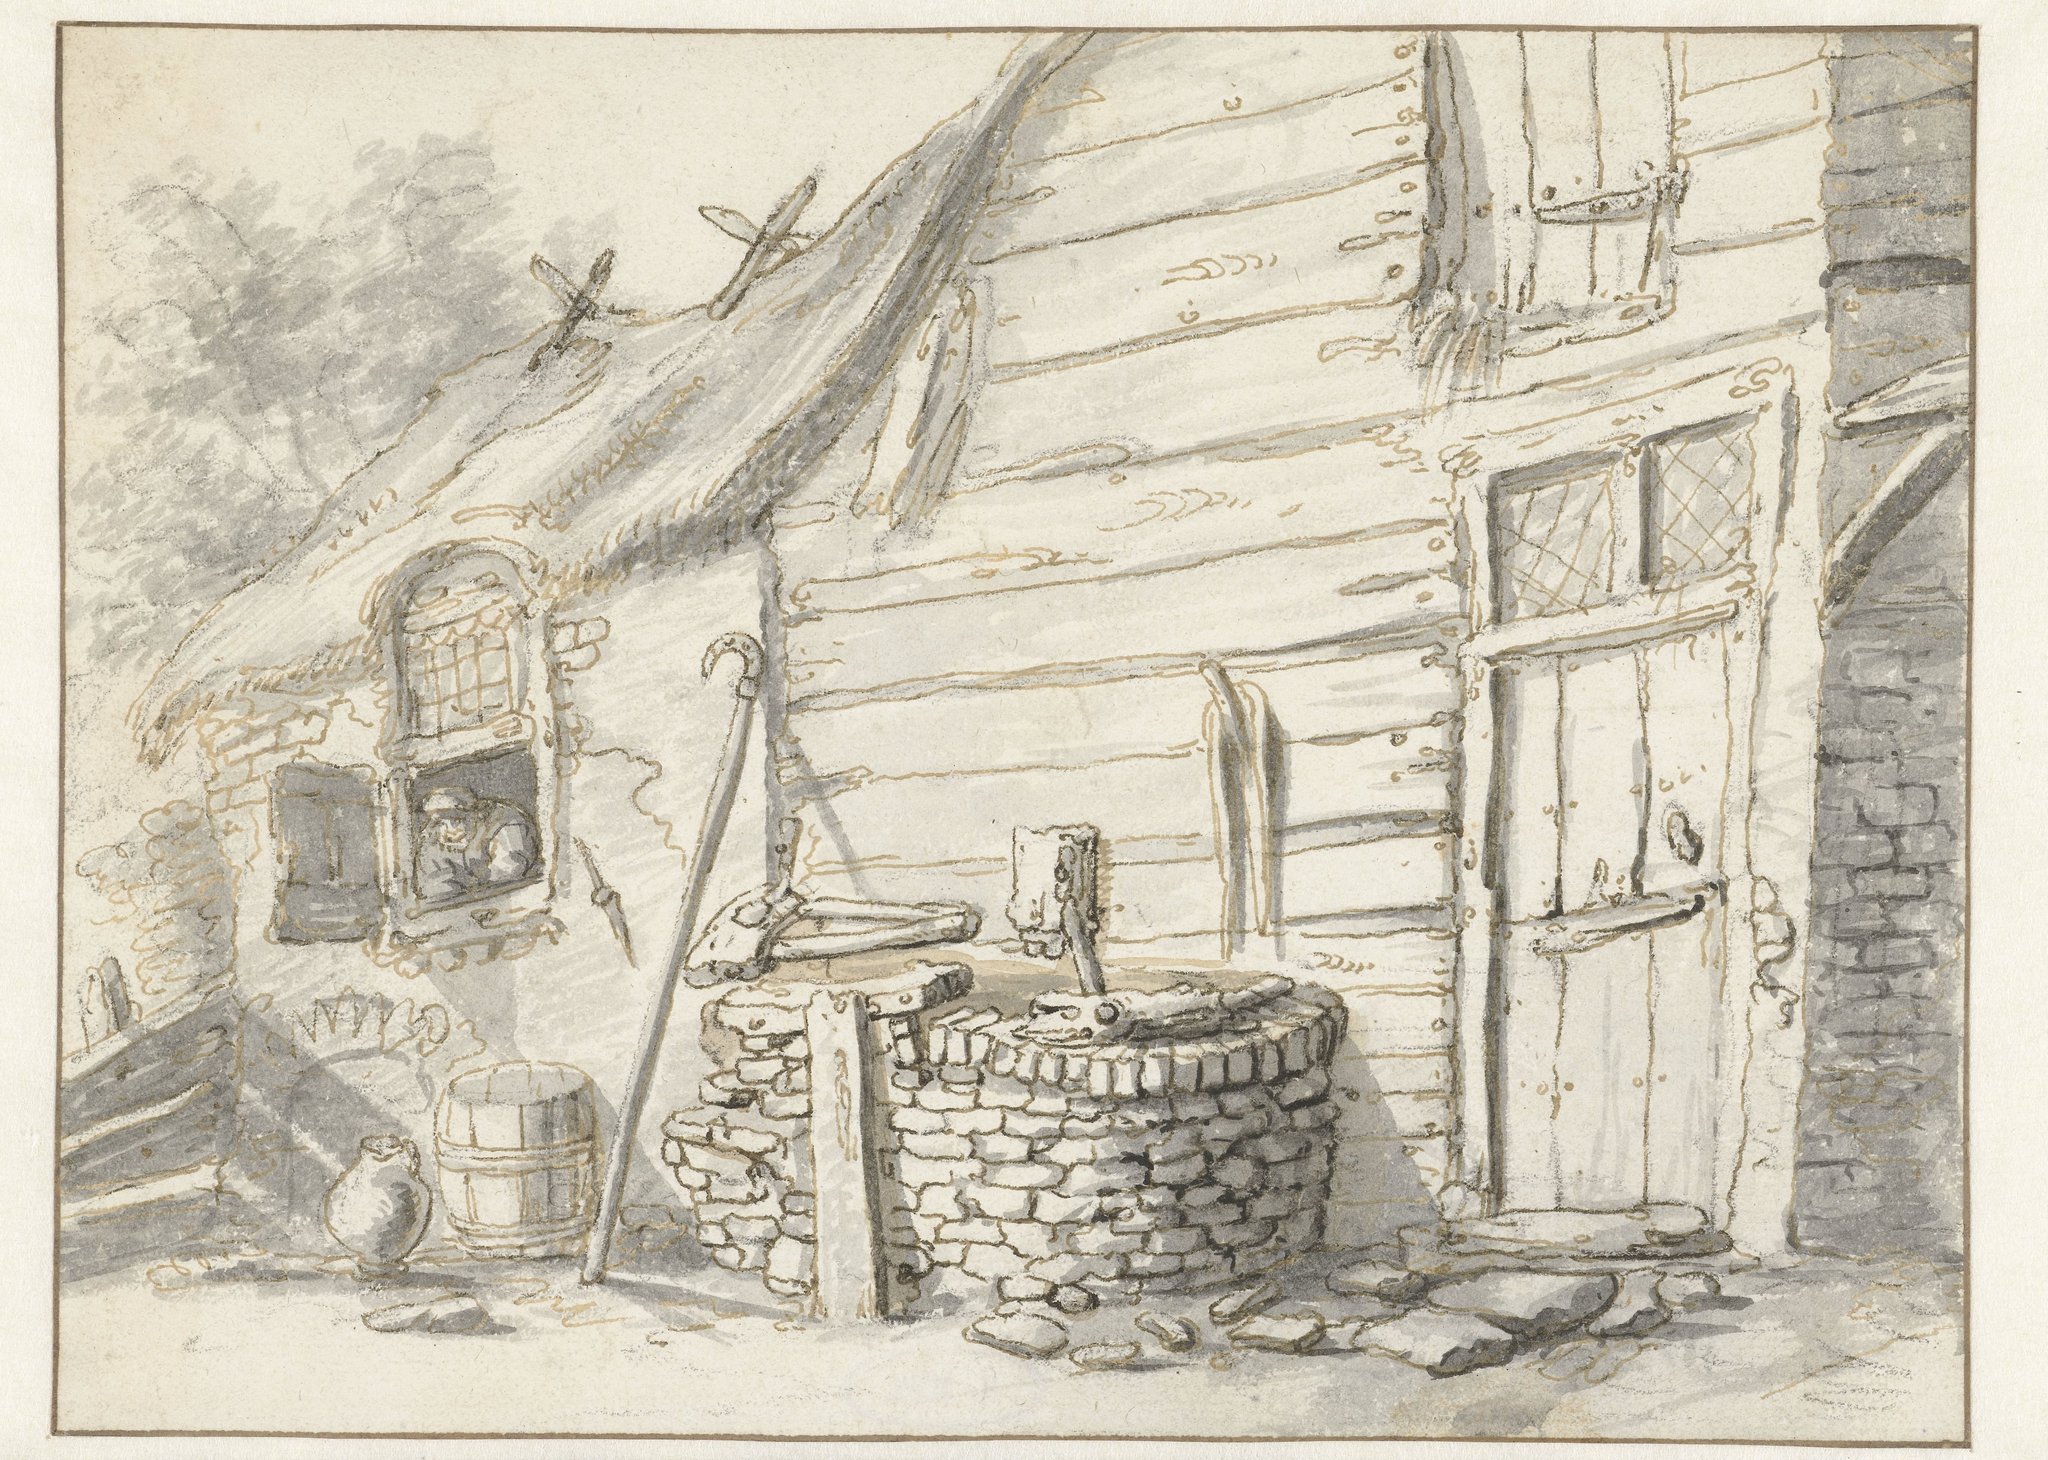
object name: drawing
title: Boerenwoning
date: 1630-1670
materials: chalk, ink, paper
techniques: brush, pen